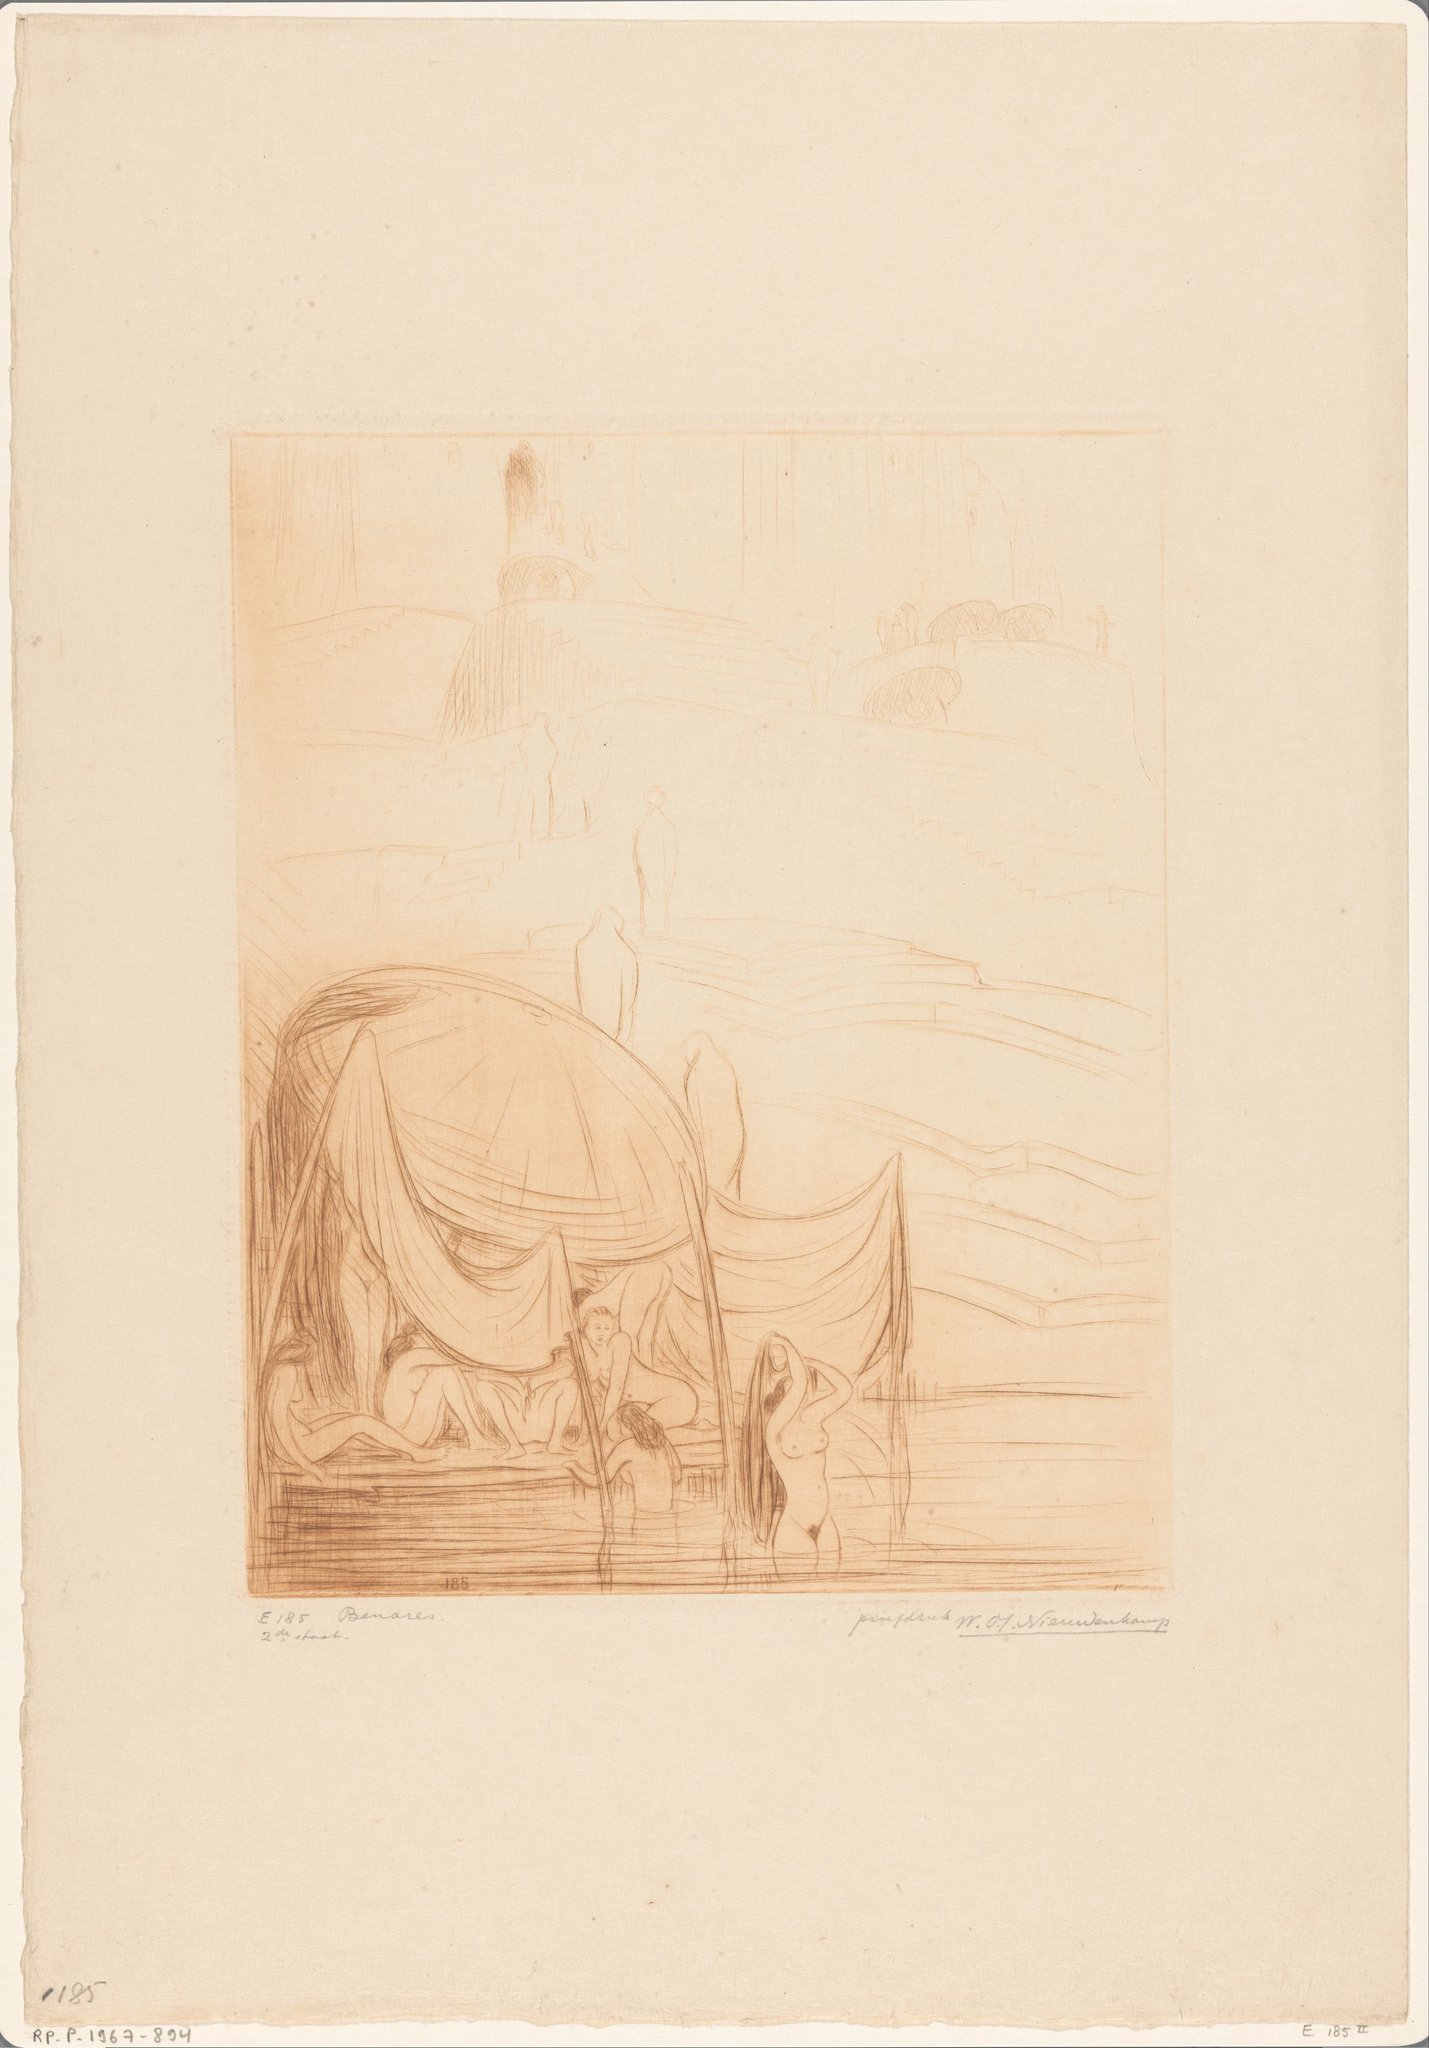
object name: print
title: Badende meisjes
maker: wijnand otto jan nieuwenkamp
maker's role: draughtsman, print maker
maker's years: 1874-1950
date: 1903-1917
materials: paper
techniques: drypoint, intaglio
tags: river, sloping street; street with steps or stairs, taking a bath - aa - in the open air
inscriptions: collector's mark: Lugt 2228, collector's mark: Lugt 2760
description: Op de achtergrond ghats, trappen die naar de rivier toe leiden.